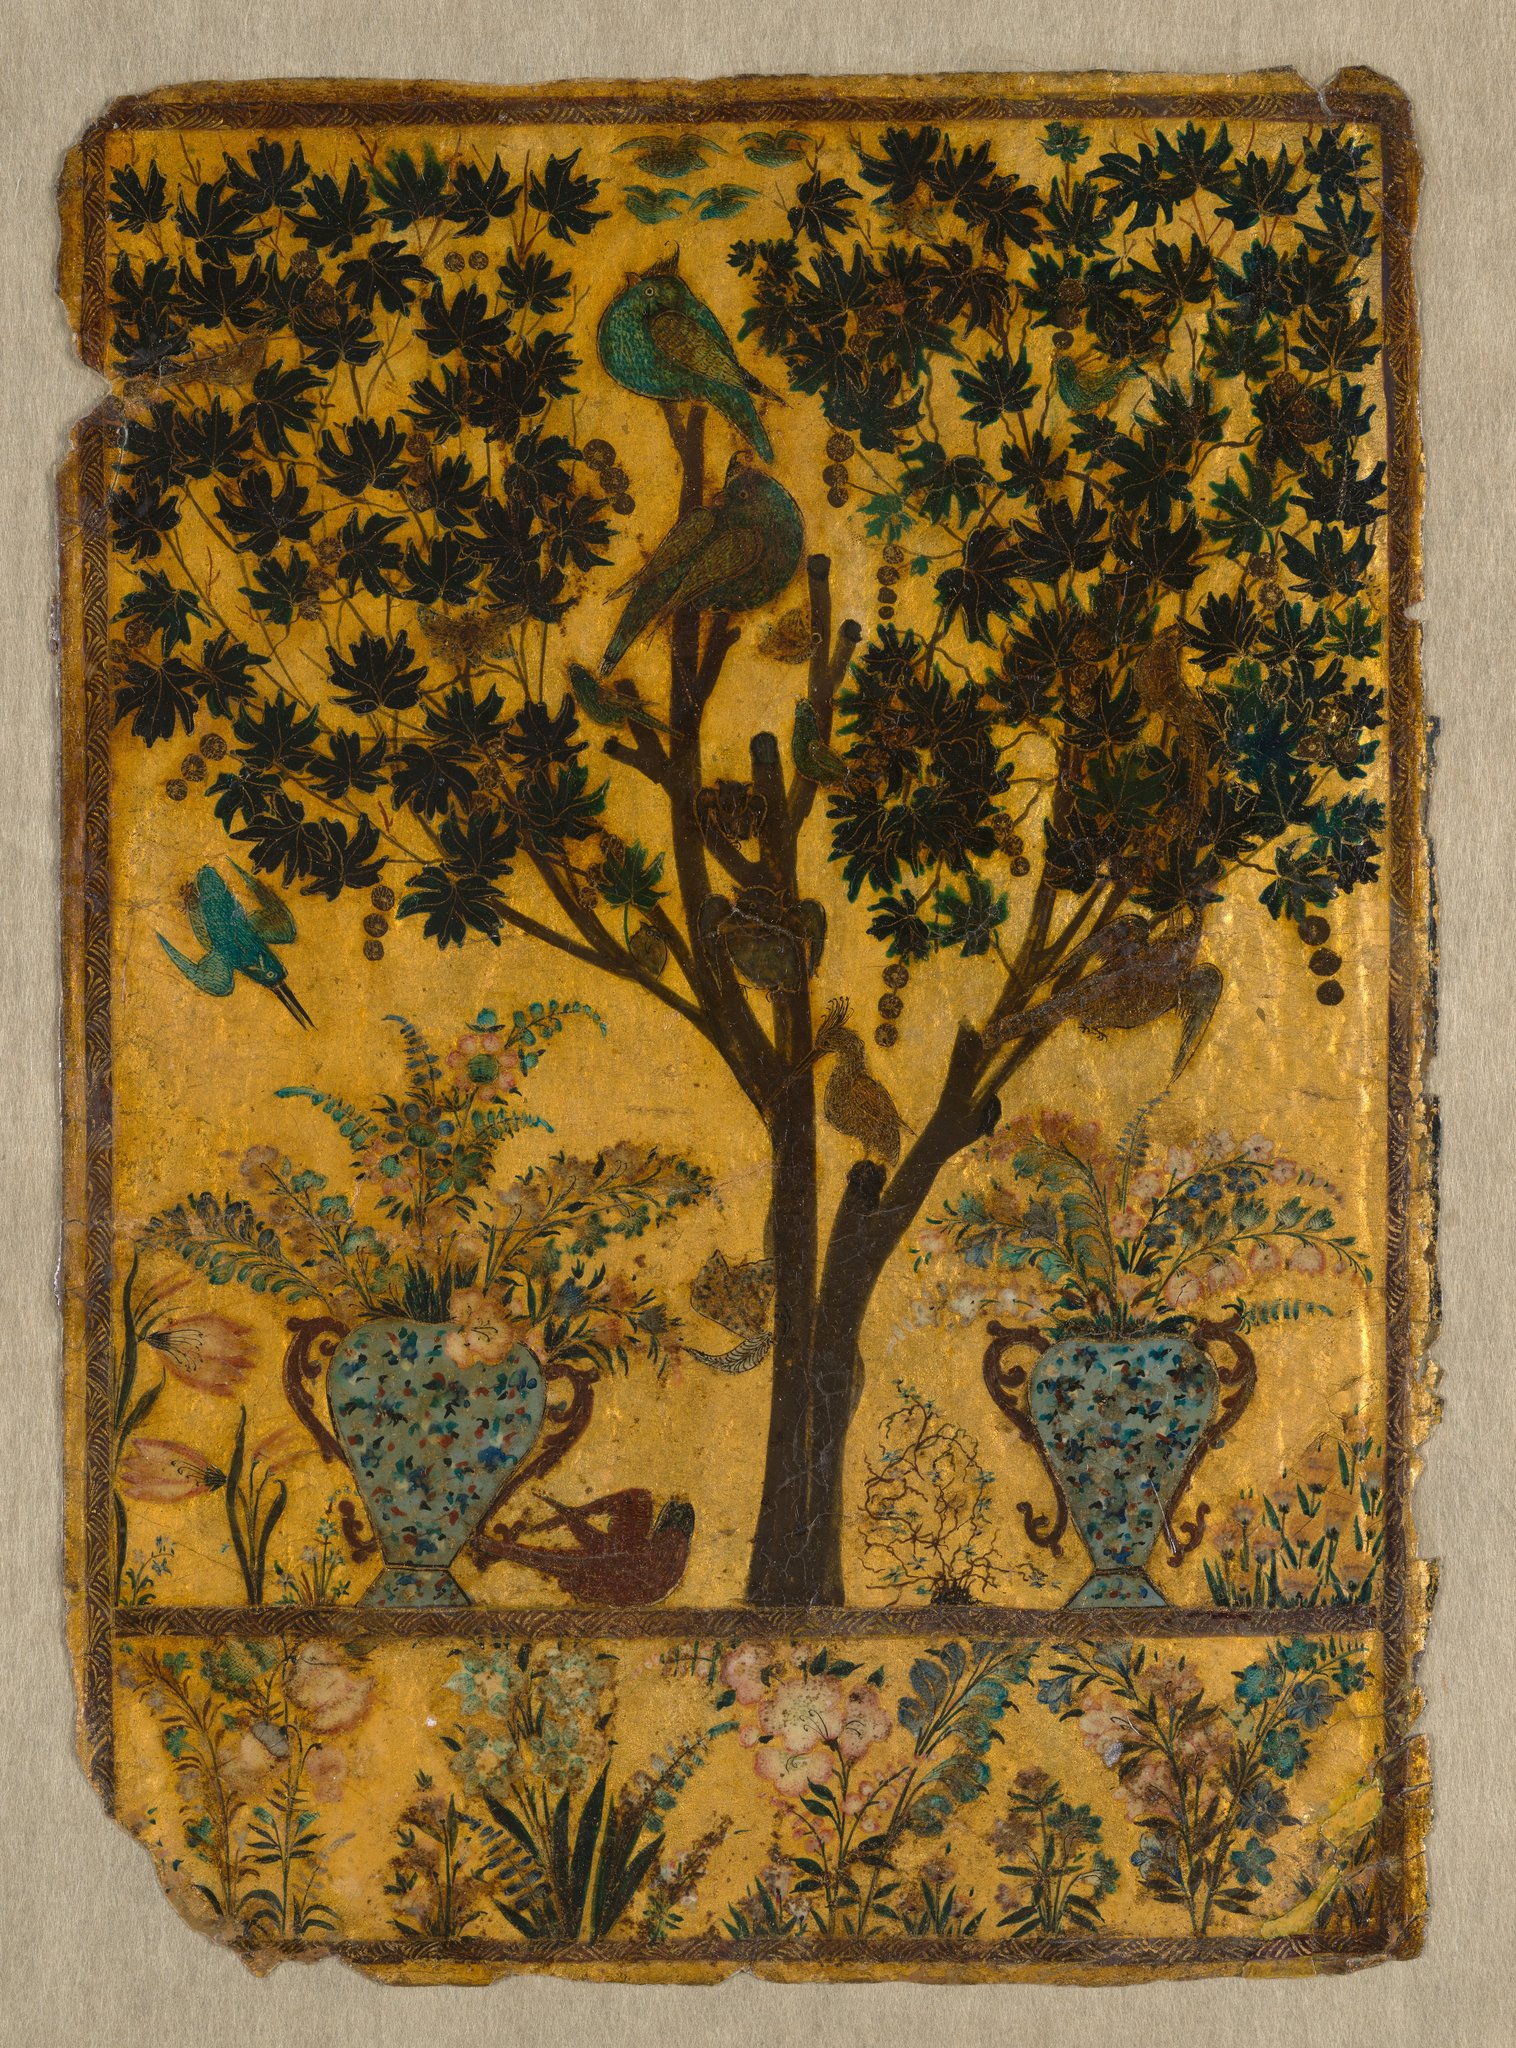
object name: book cover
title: Book Cover with Tree, Birds, and Insects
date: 1700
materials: gold, gouache, lacquer, leather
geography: india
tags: trees